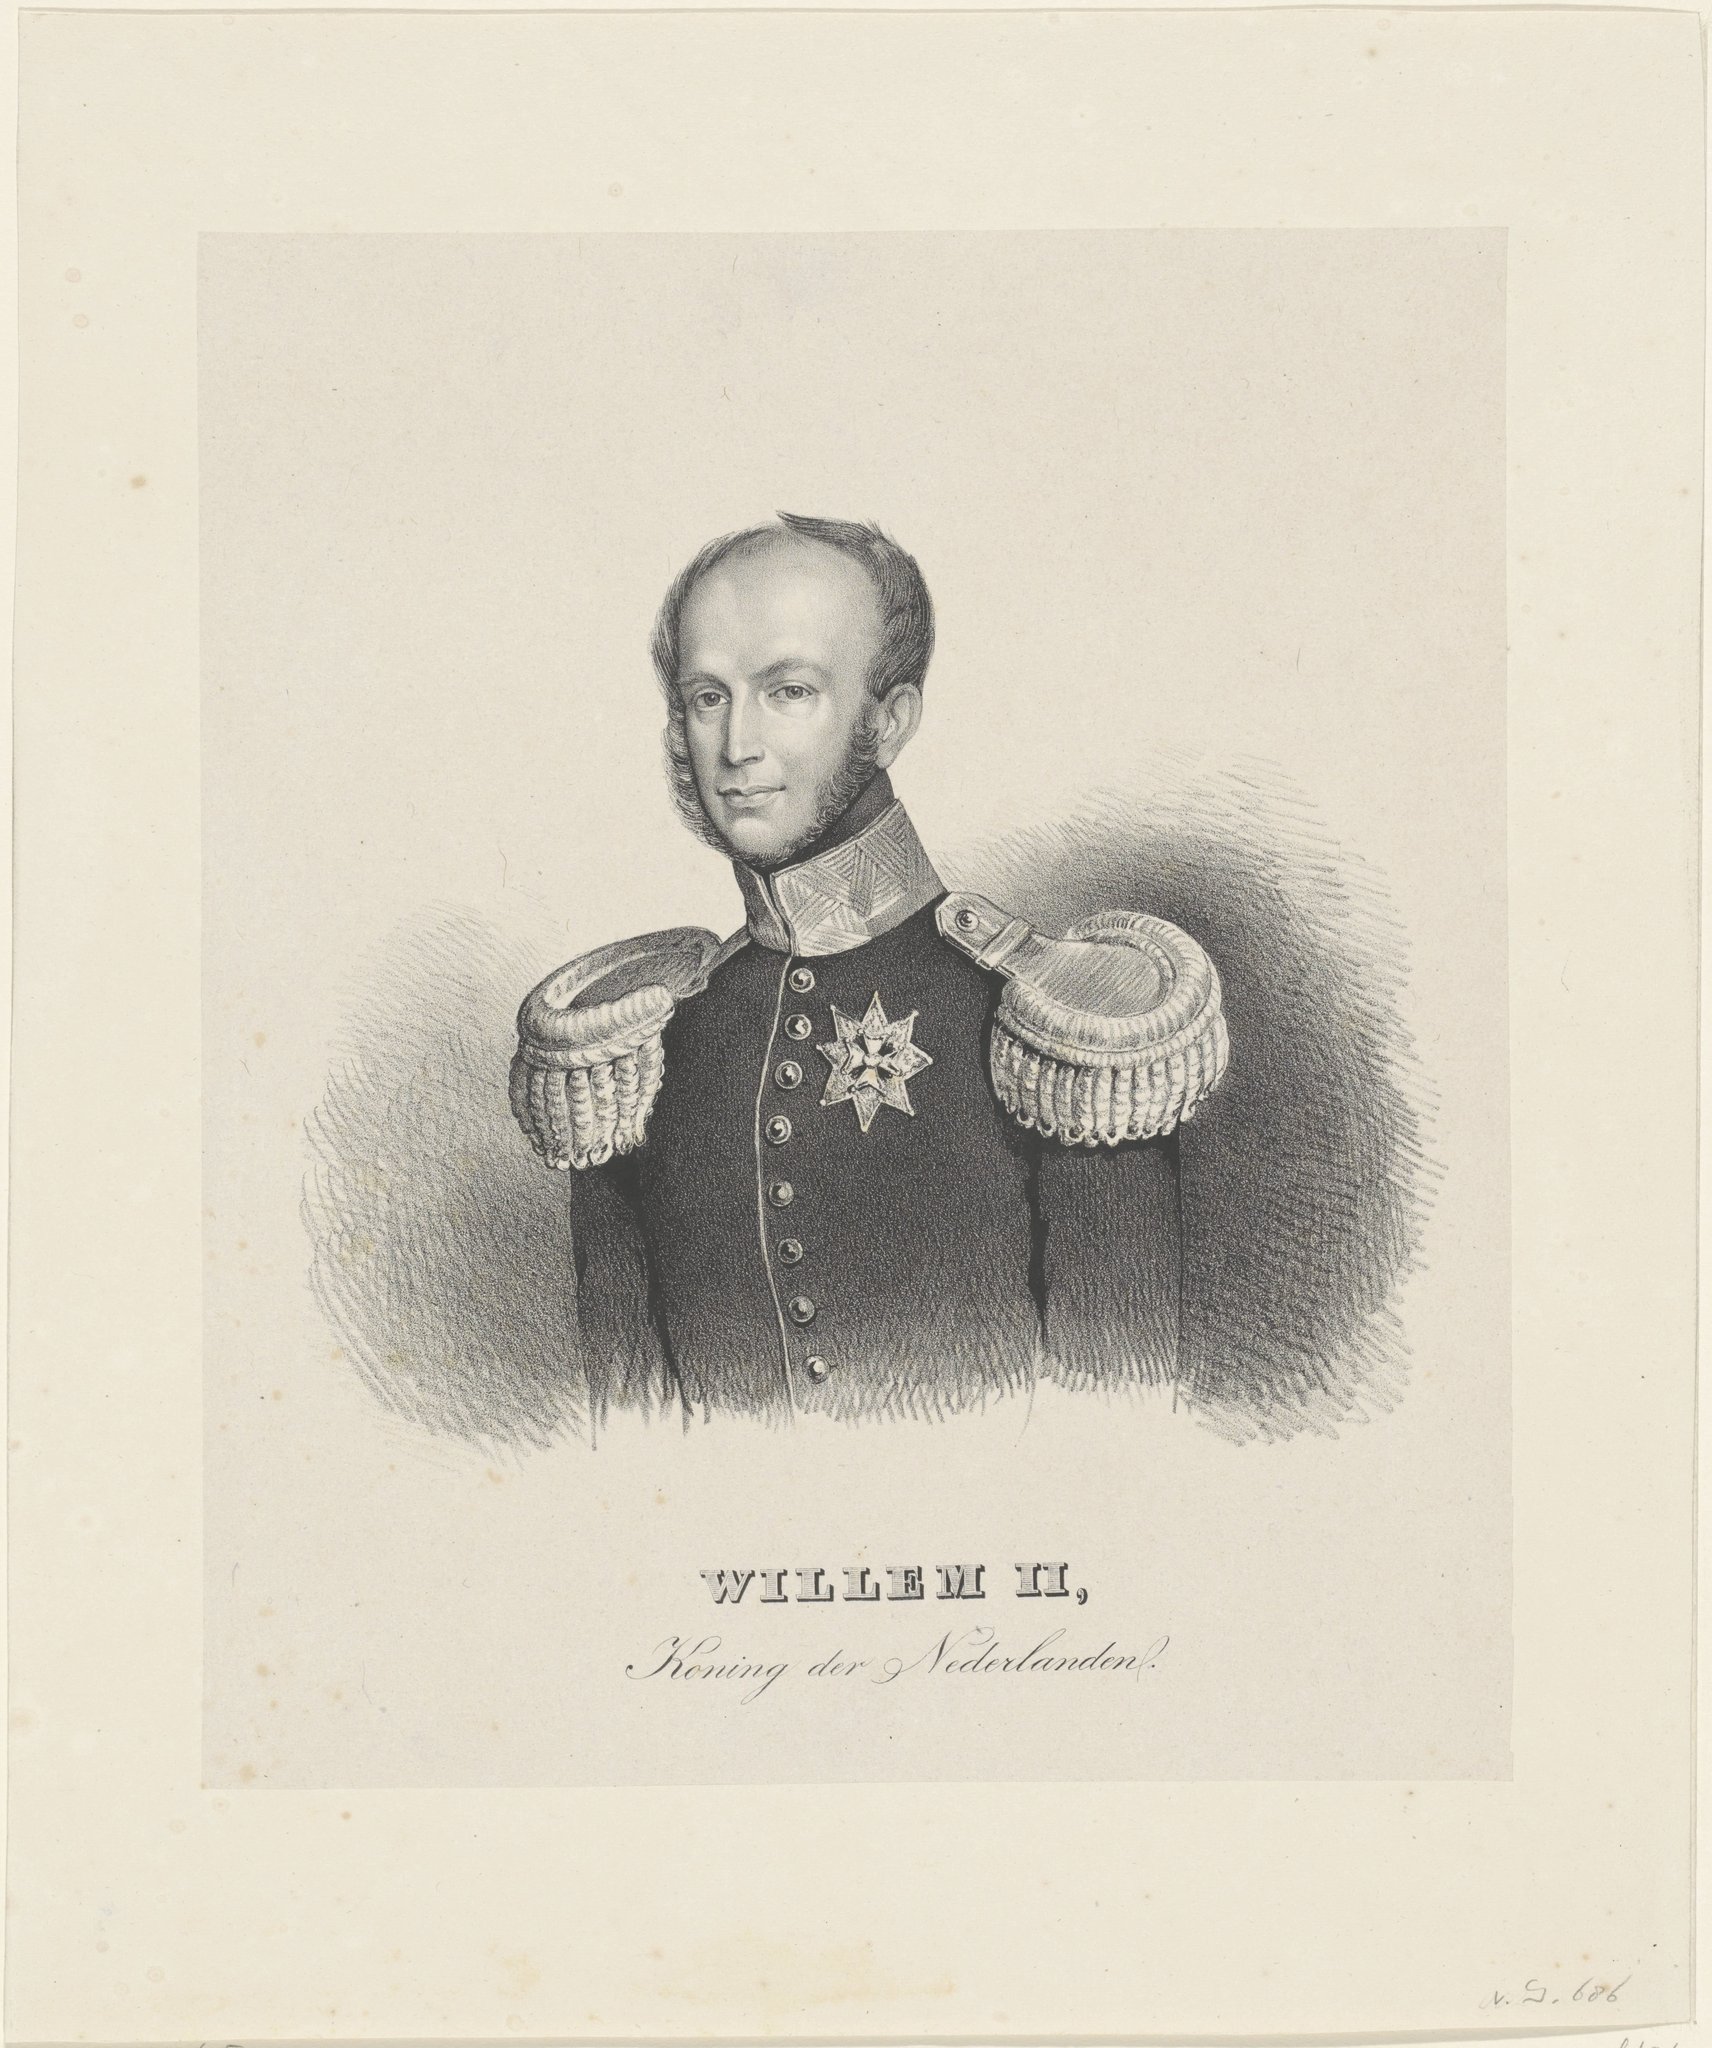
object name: print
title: Portret van Willem II, koning der Nederlanden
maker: Anonymous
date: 1840-1899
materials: paper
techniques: lithograph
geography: netherlands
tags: william ii of the netherlands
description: De hier vermelde titel verwijst naar de hoogst verkregen titel van de geportretteerde, niet per se naar de titel die de geportretteerde op deze voorstelling draagt.